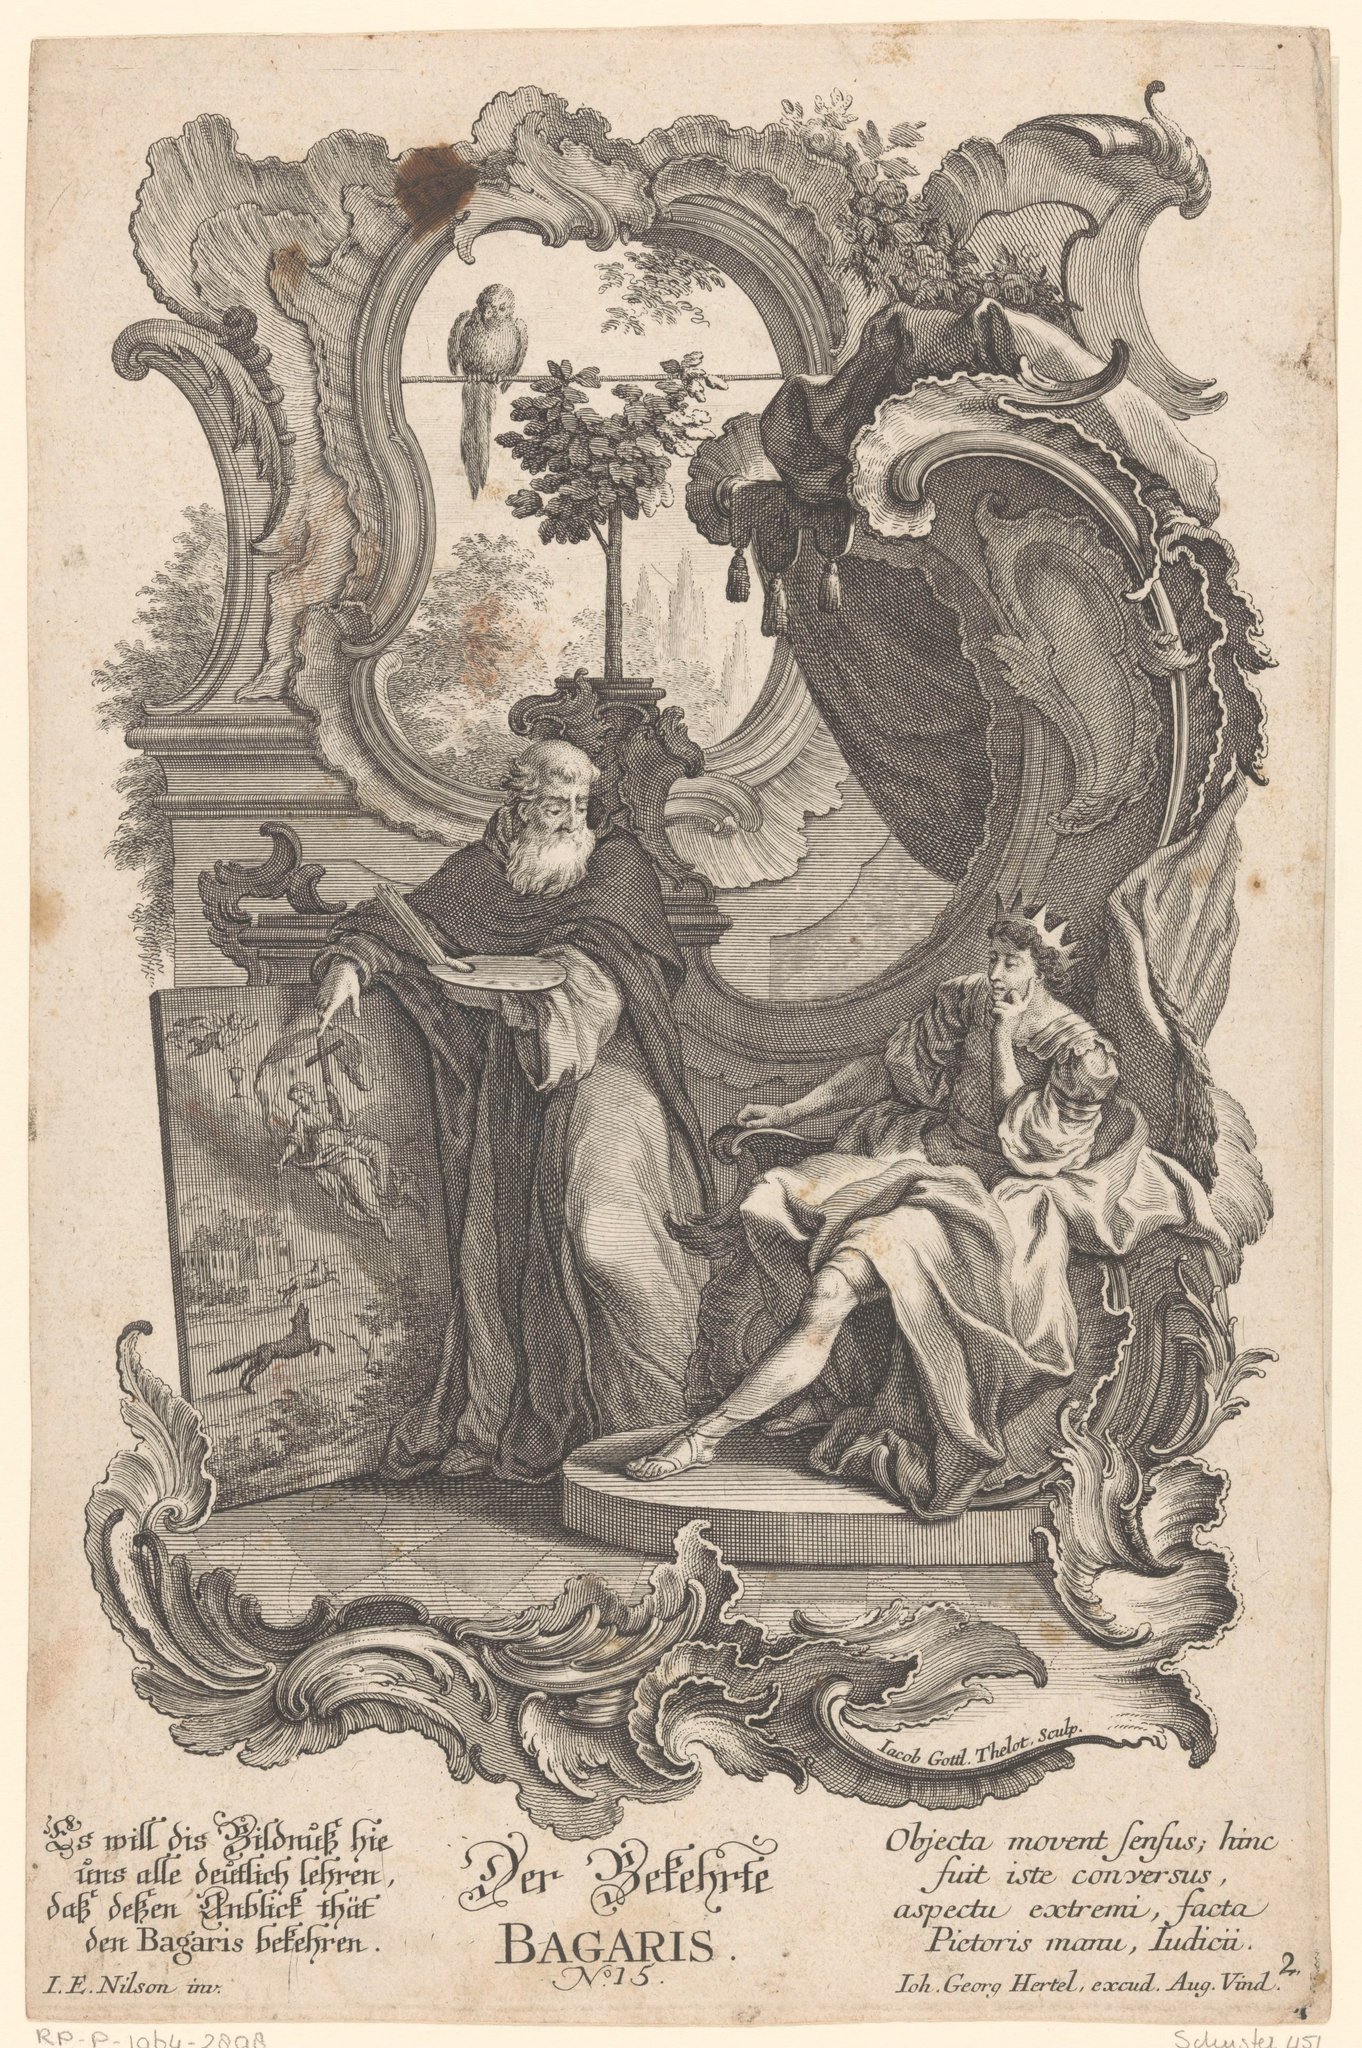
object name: ornament print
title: Apelles en Bagaris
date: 1731-1760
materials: paper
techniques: engraving, etching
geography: augsburg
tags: criticizing and discussing art, art criticism, monk(s), friar(s), king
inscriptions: collector's mark: Lugt 2760, collector's mark: Lugt 2228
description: Rechts op een rocaille troon zit de jonge koning Bagaris. Hij kijkt naar een schilderij van een madonna. Rechts naast het schilderij staat een monnik met schilderspalet in zijn hand. In de achtergrond rocaille ornamenten met doorkijk naar een landschap. In de ondermarge tweemaal een vierregelige Duitse en Latijnse tekst. Uitgeversnummer 15.